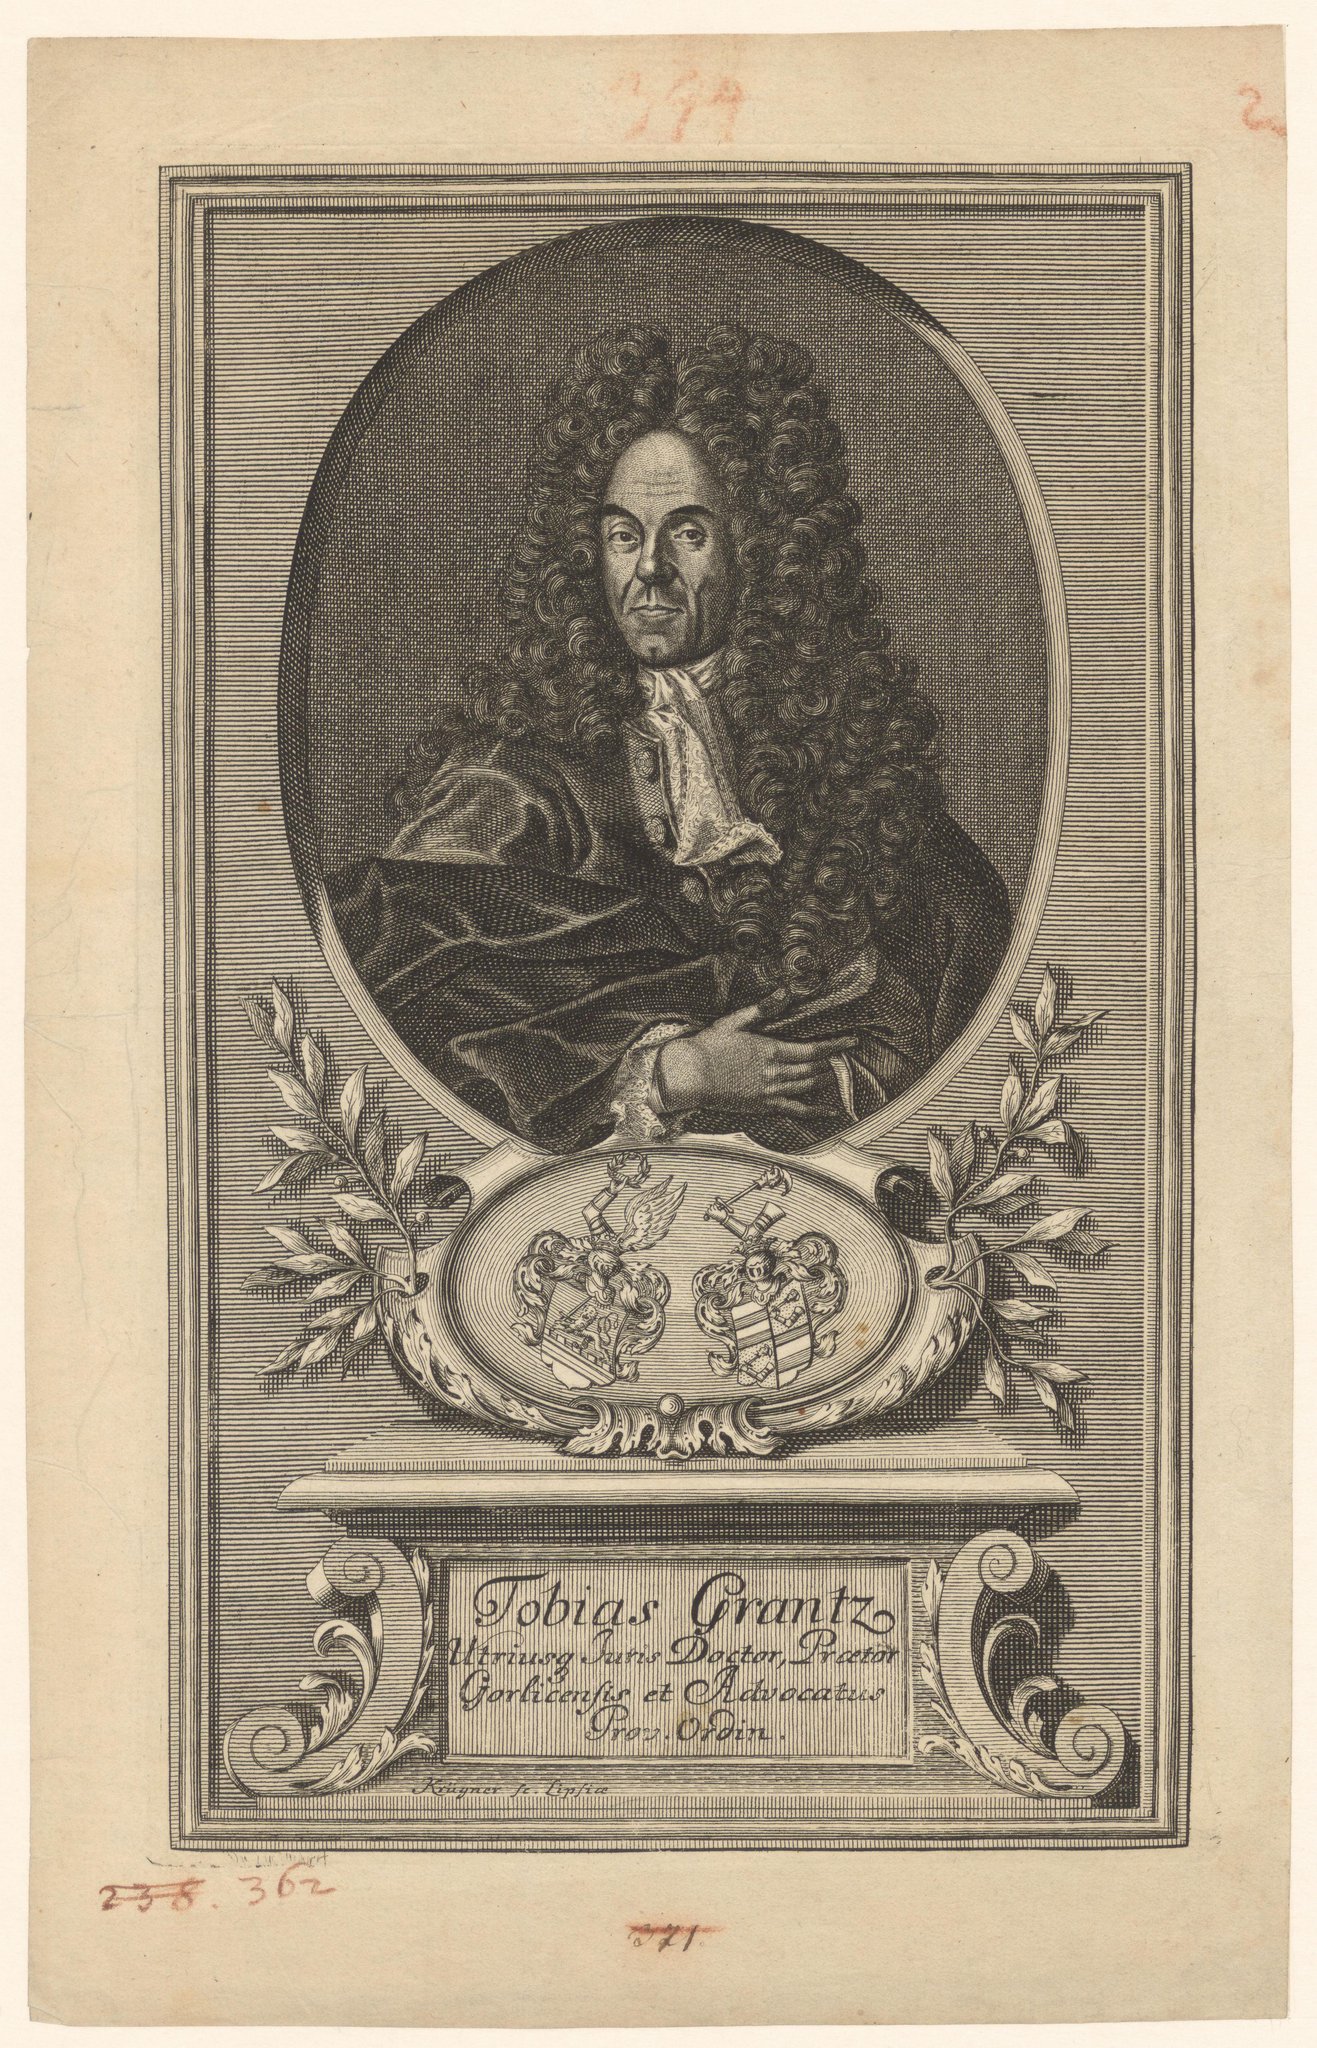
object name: print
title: Portret van Tobias Granz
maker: johann gottfried krügner (i)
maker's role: artist, print maker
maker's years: 1684-1769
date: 1705-1769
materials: paper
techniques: engraving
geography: leipzig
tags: historical persons, lawyer, attorney at law, counsellor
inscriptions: collector's mark: Lugt 2228